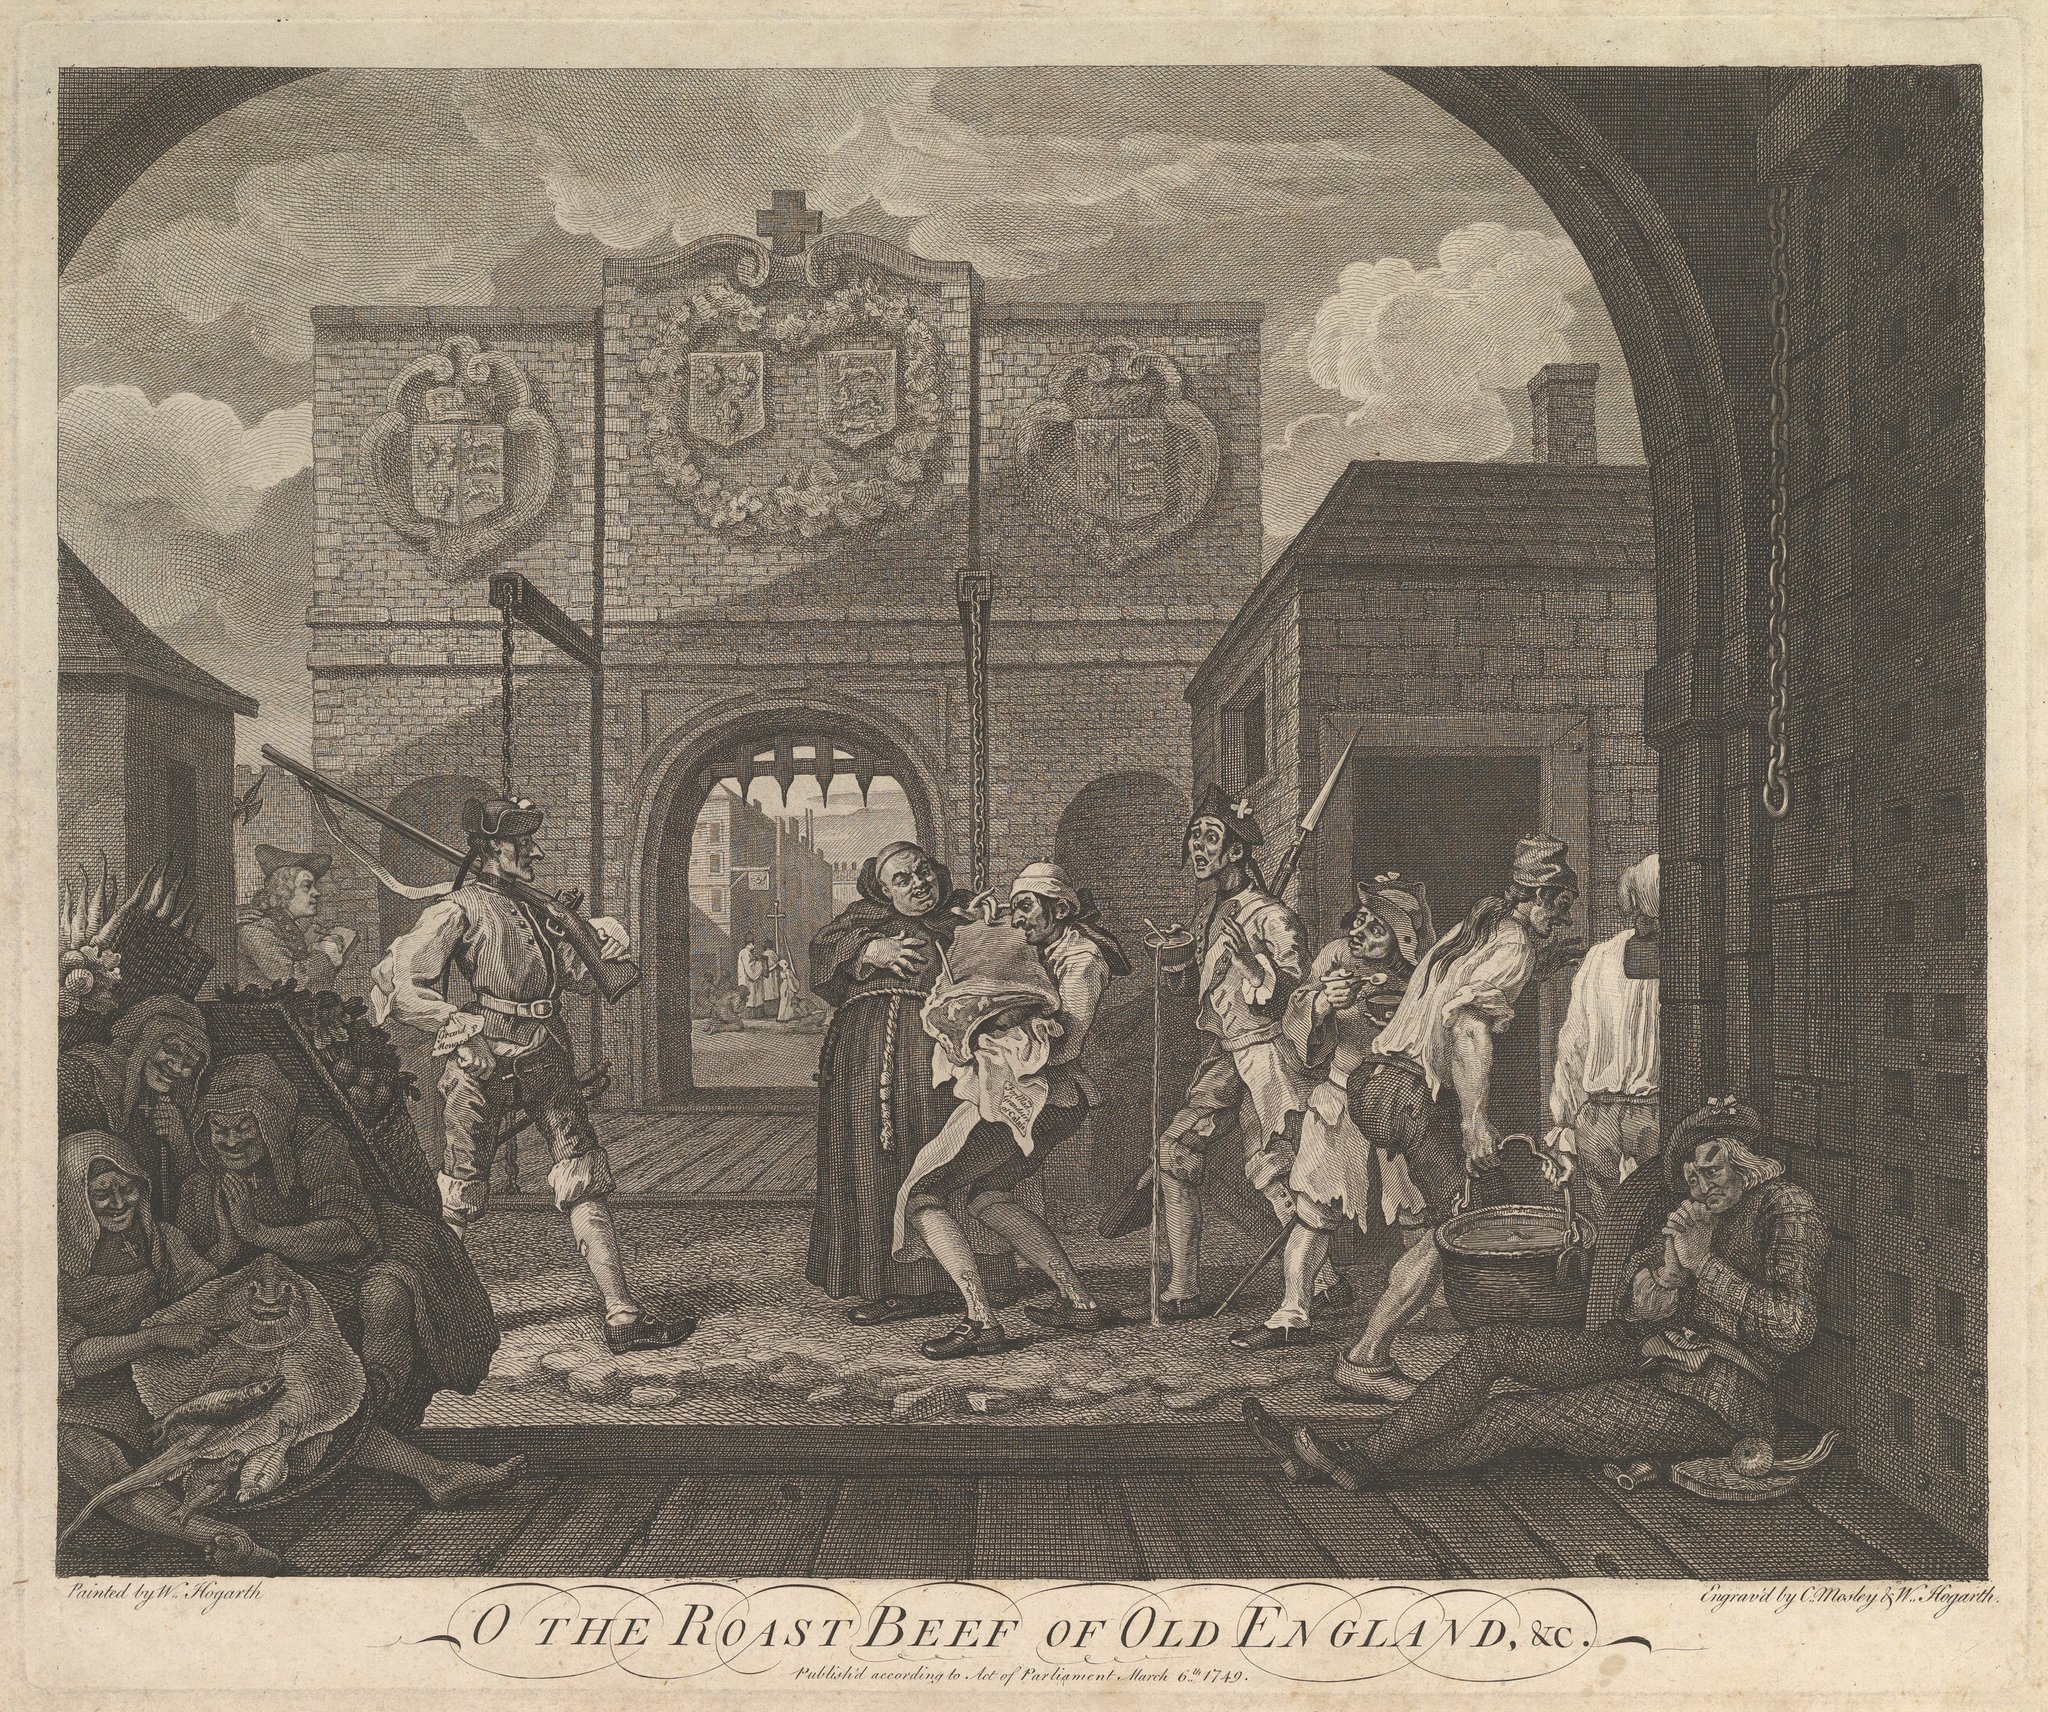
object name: print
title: O the Roast Beef of Old England--The Gate of Caiais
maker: william hogarth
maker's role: artist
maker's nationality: british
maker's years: 1697-1764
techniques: engraving, etching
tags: gates,men